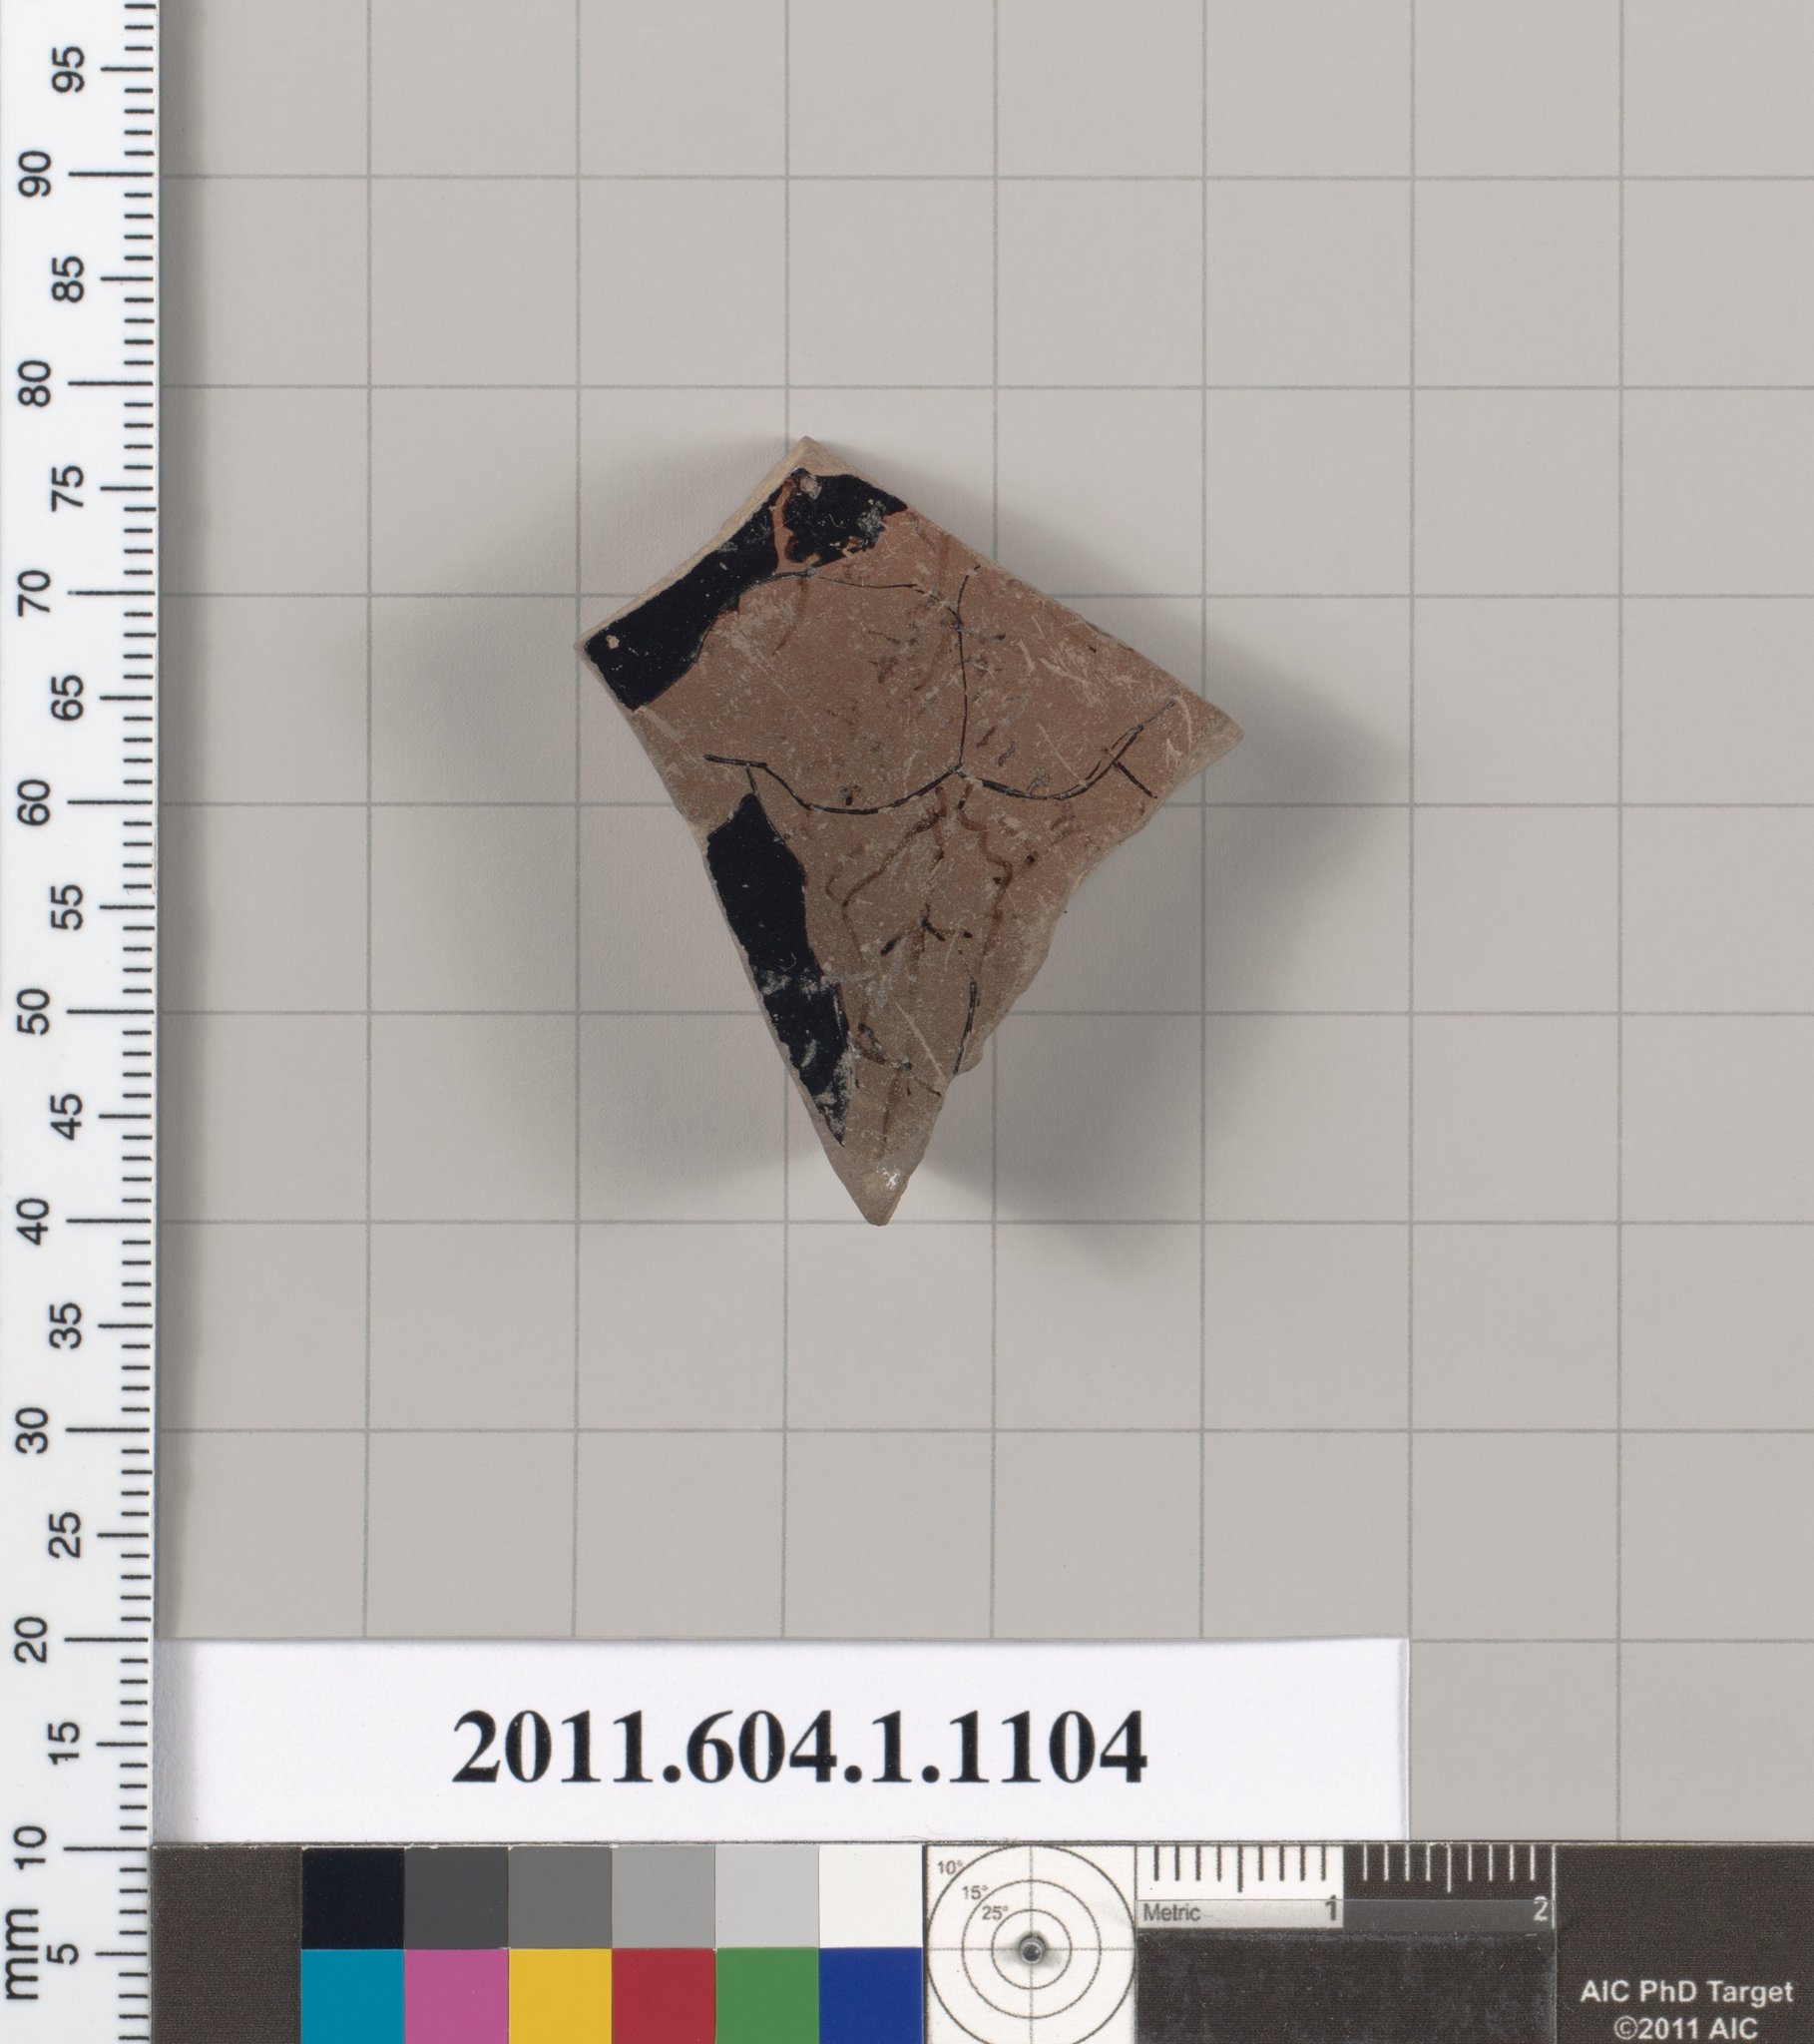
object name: kylix fragment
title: Terracotta fragment of a kylix (drinking cup)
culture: greek, attic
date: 467-435 BCE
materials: terracotta